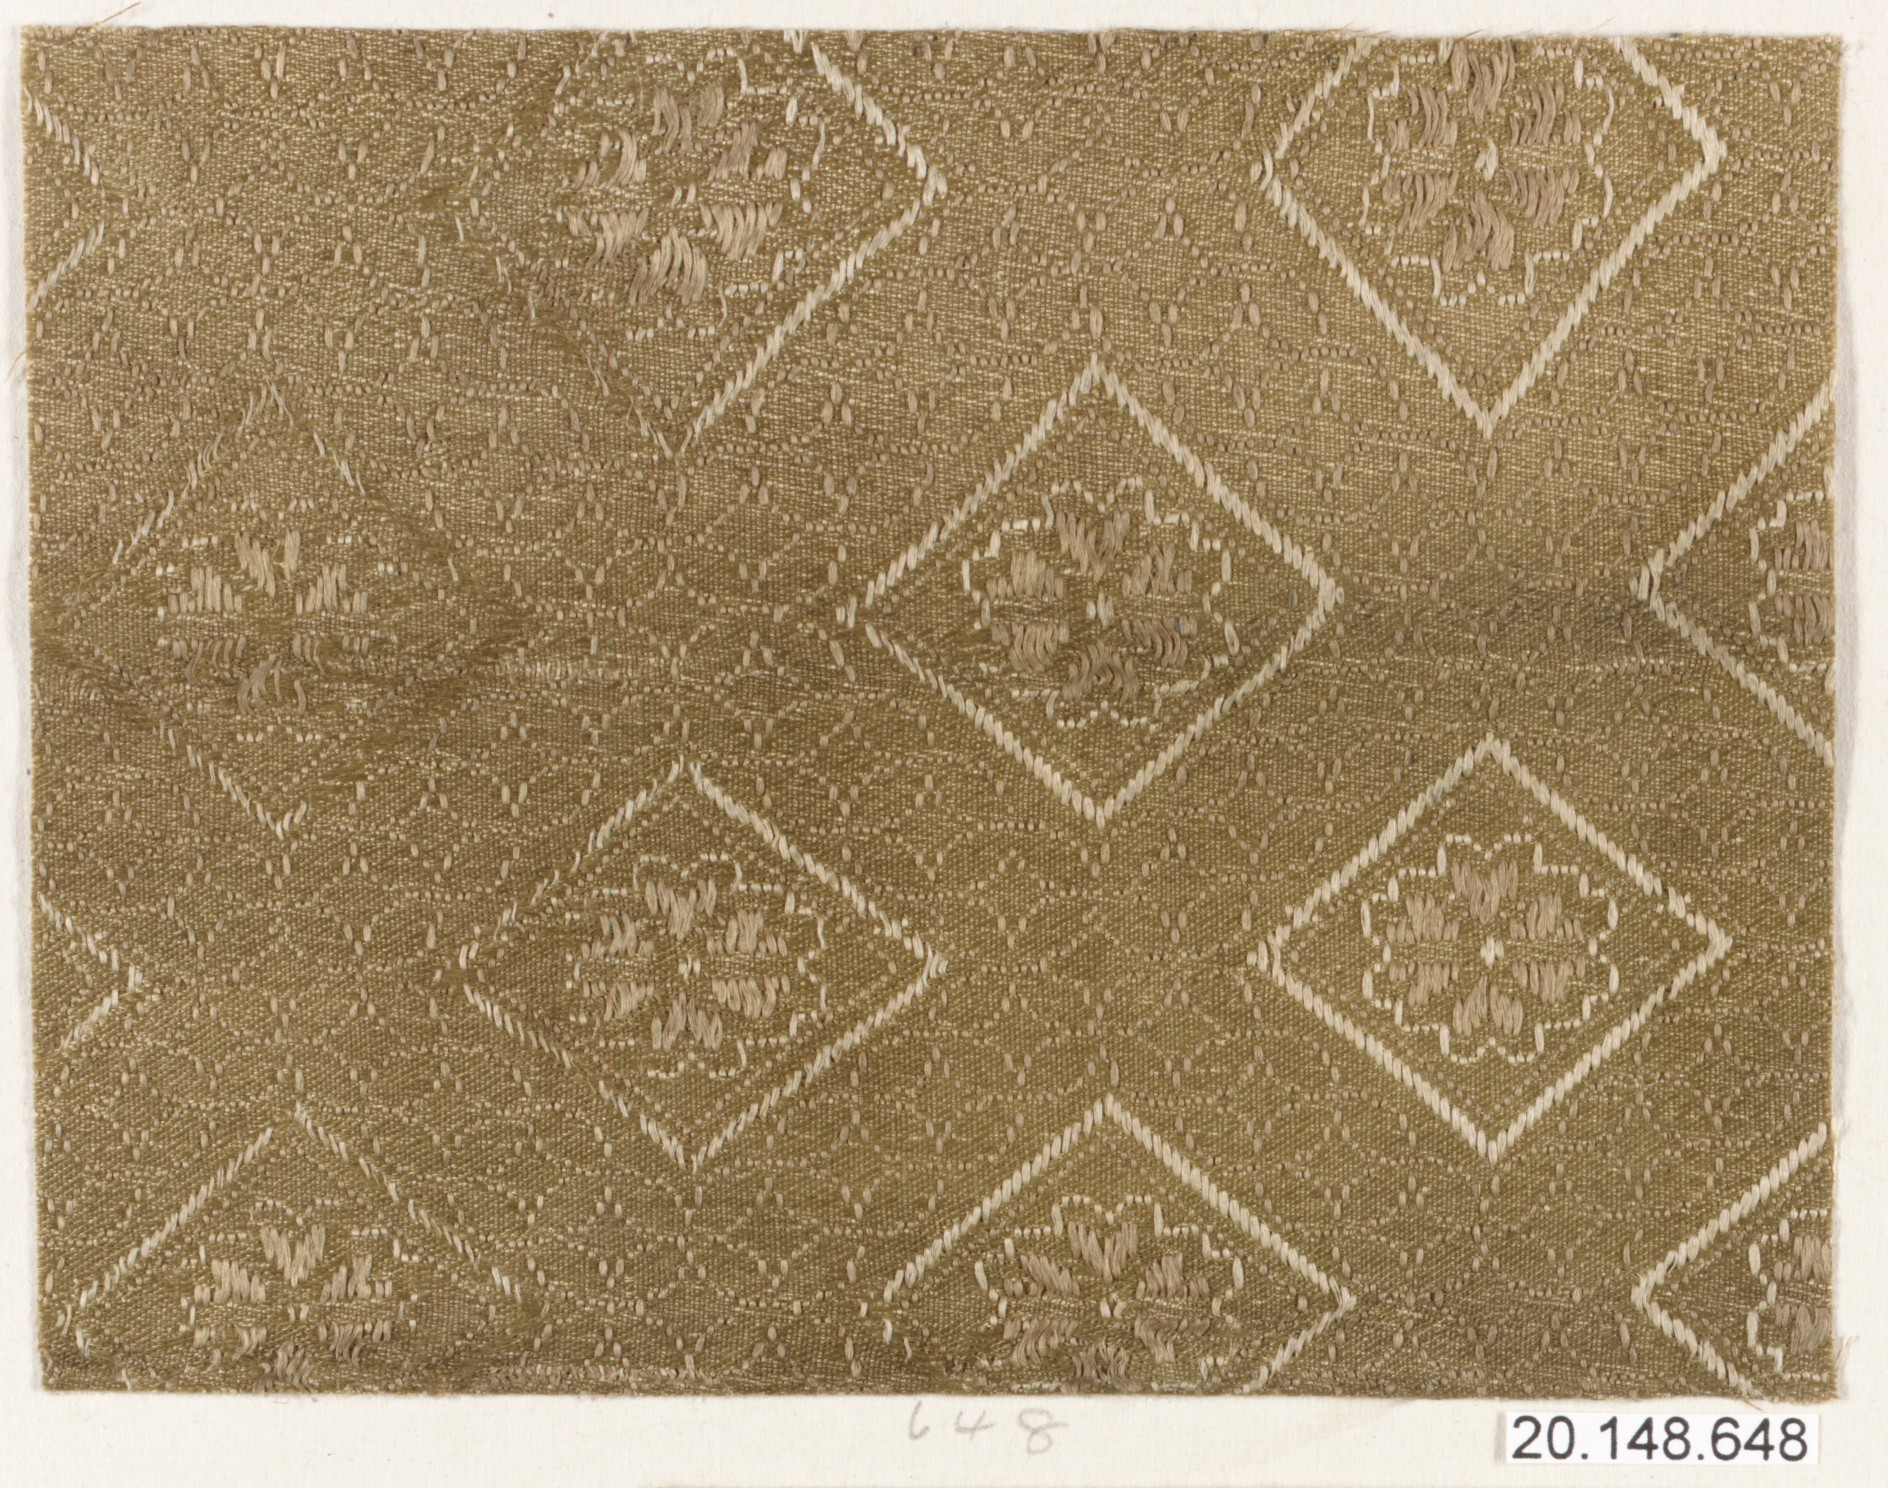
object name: piece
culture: japanese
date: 1701-1800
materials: silk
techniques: compound weave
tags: flowers